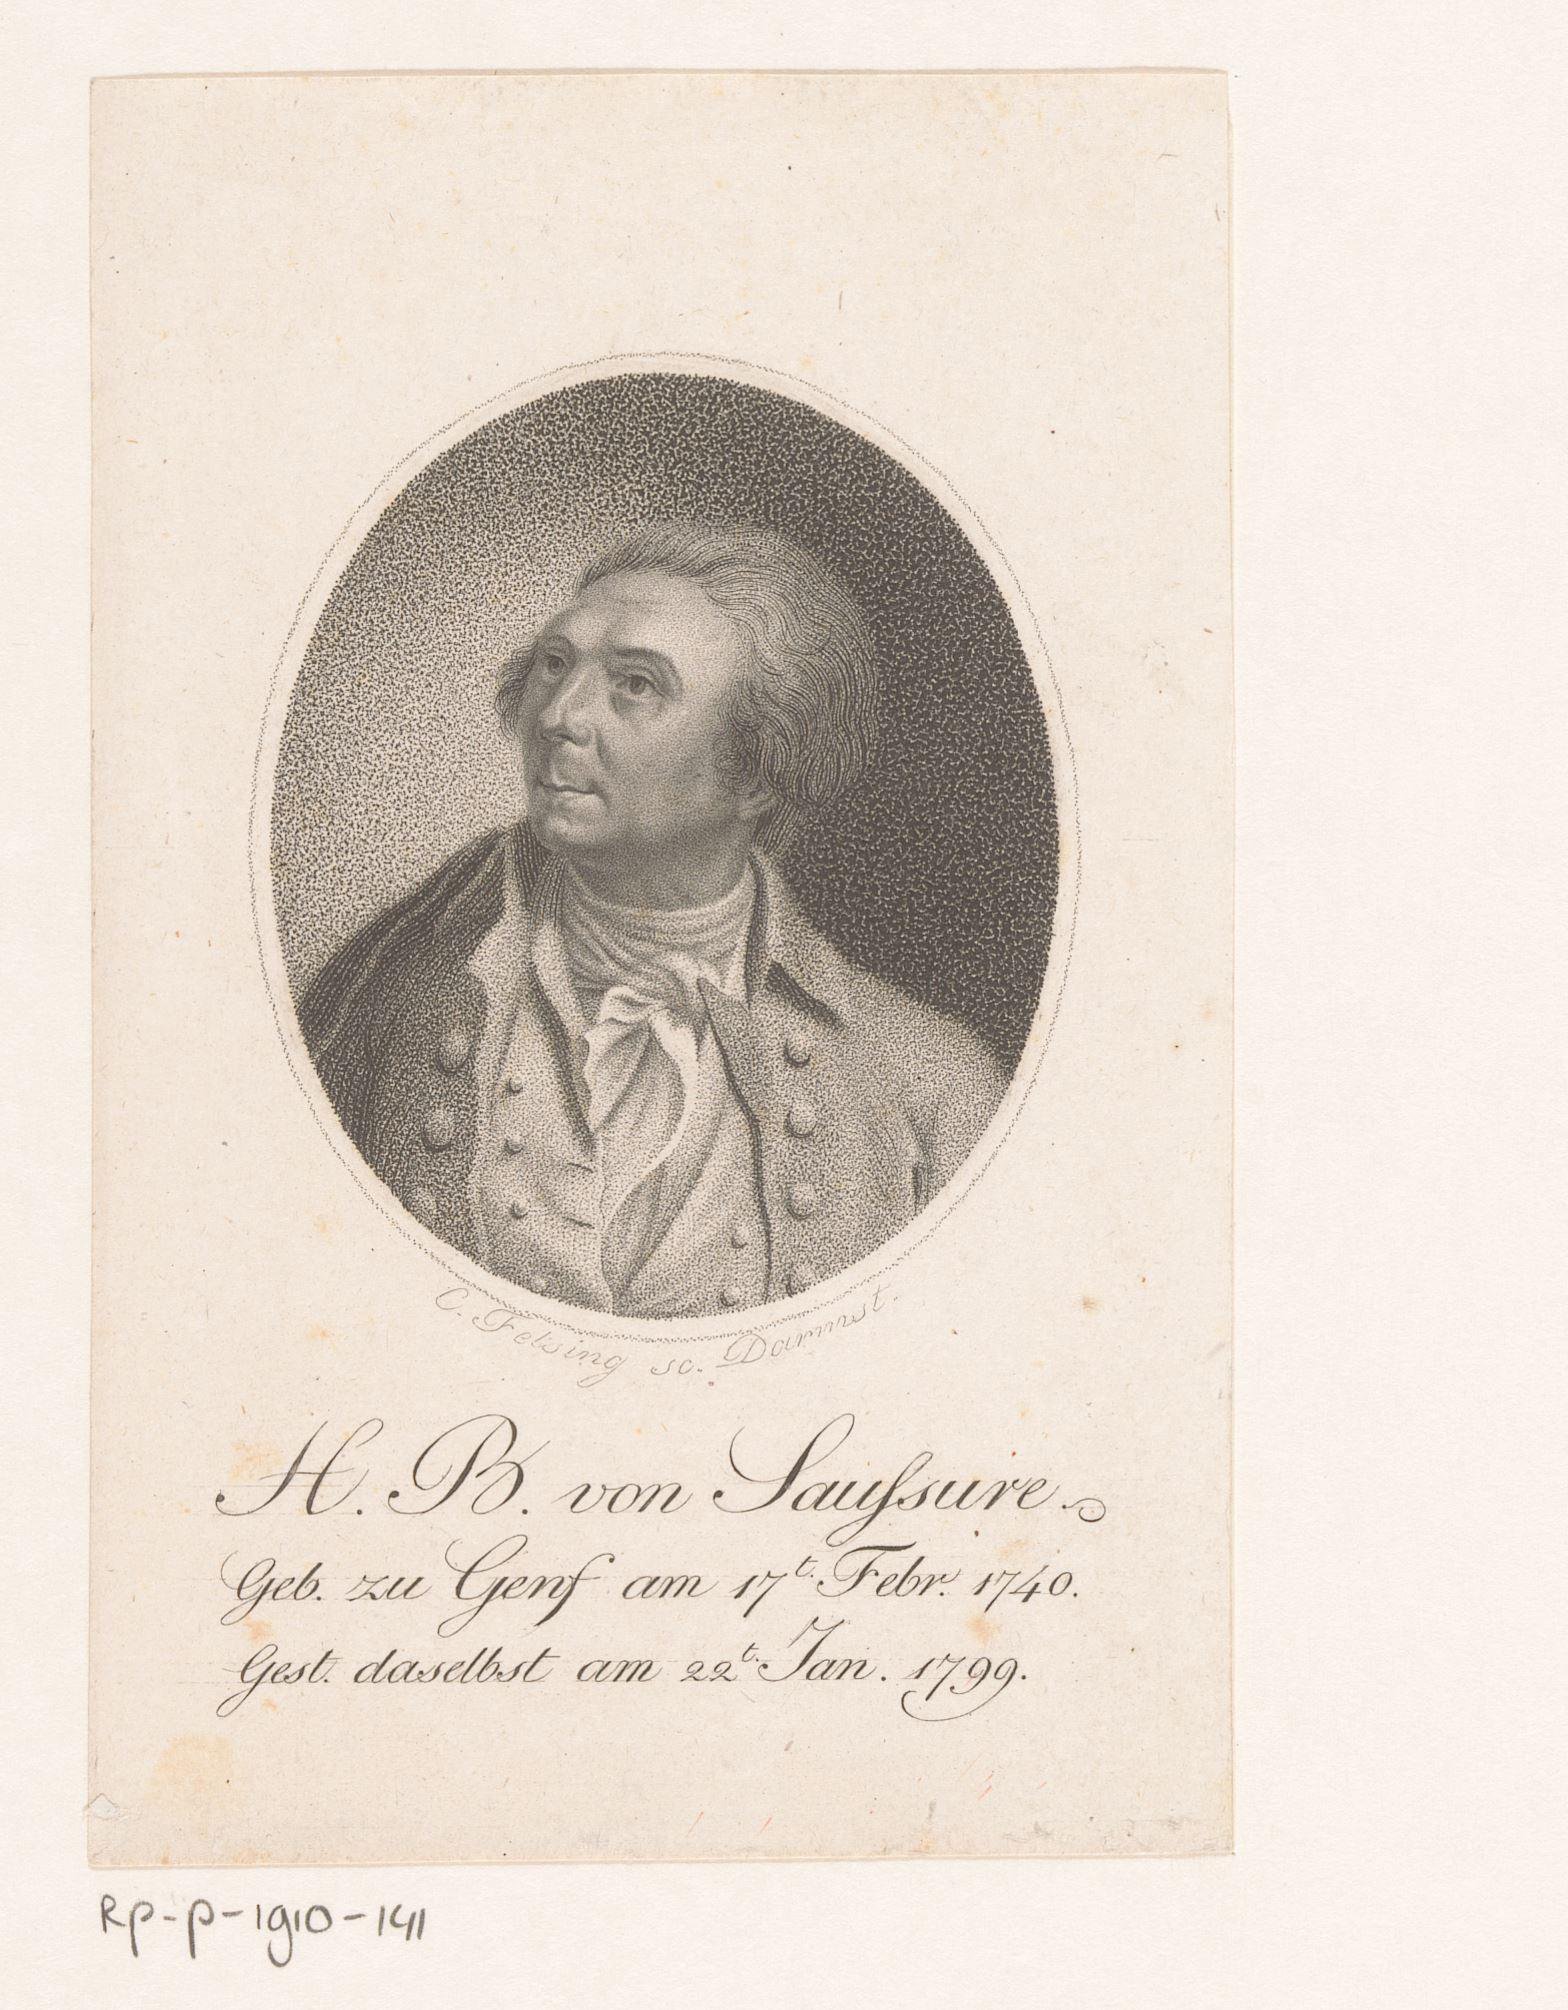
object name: print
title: Portret van Horace-Bénédict de Saussure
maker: conrad felsing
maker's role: print maker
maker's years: 1766-1819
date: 1799-1819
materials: paper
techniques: engraving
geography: darmstadt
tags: physicist, historical persons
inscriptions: collector's mark: Lugt 2228